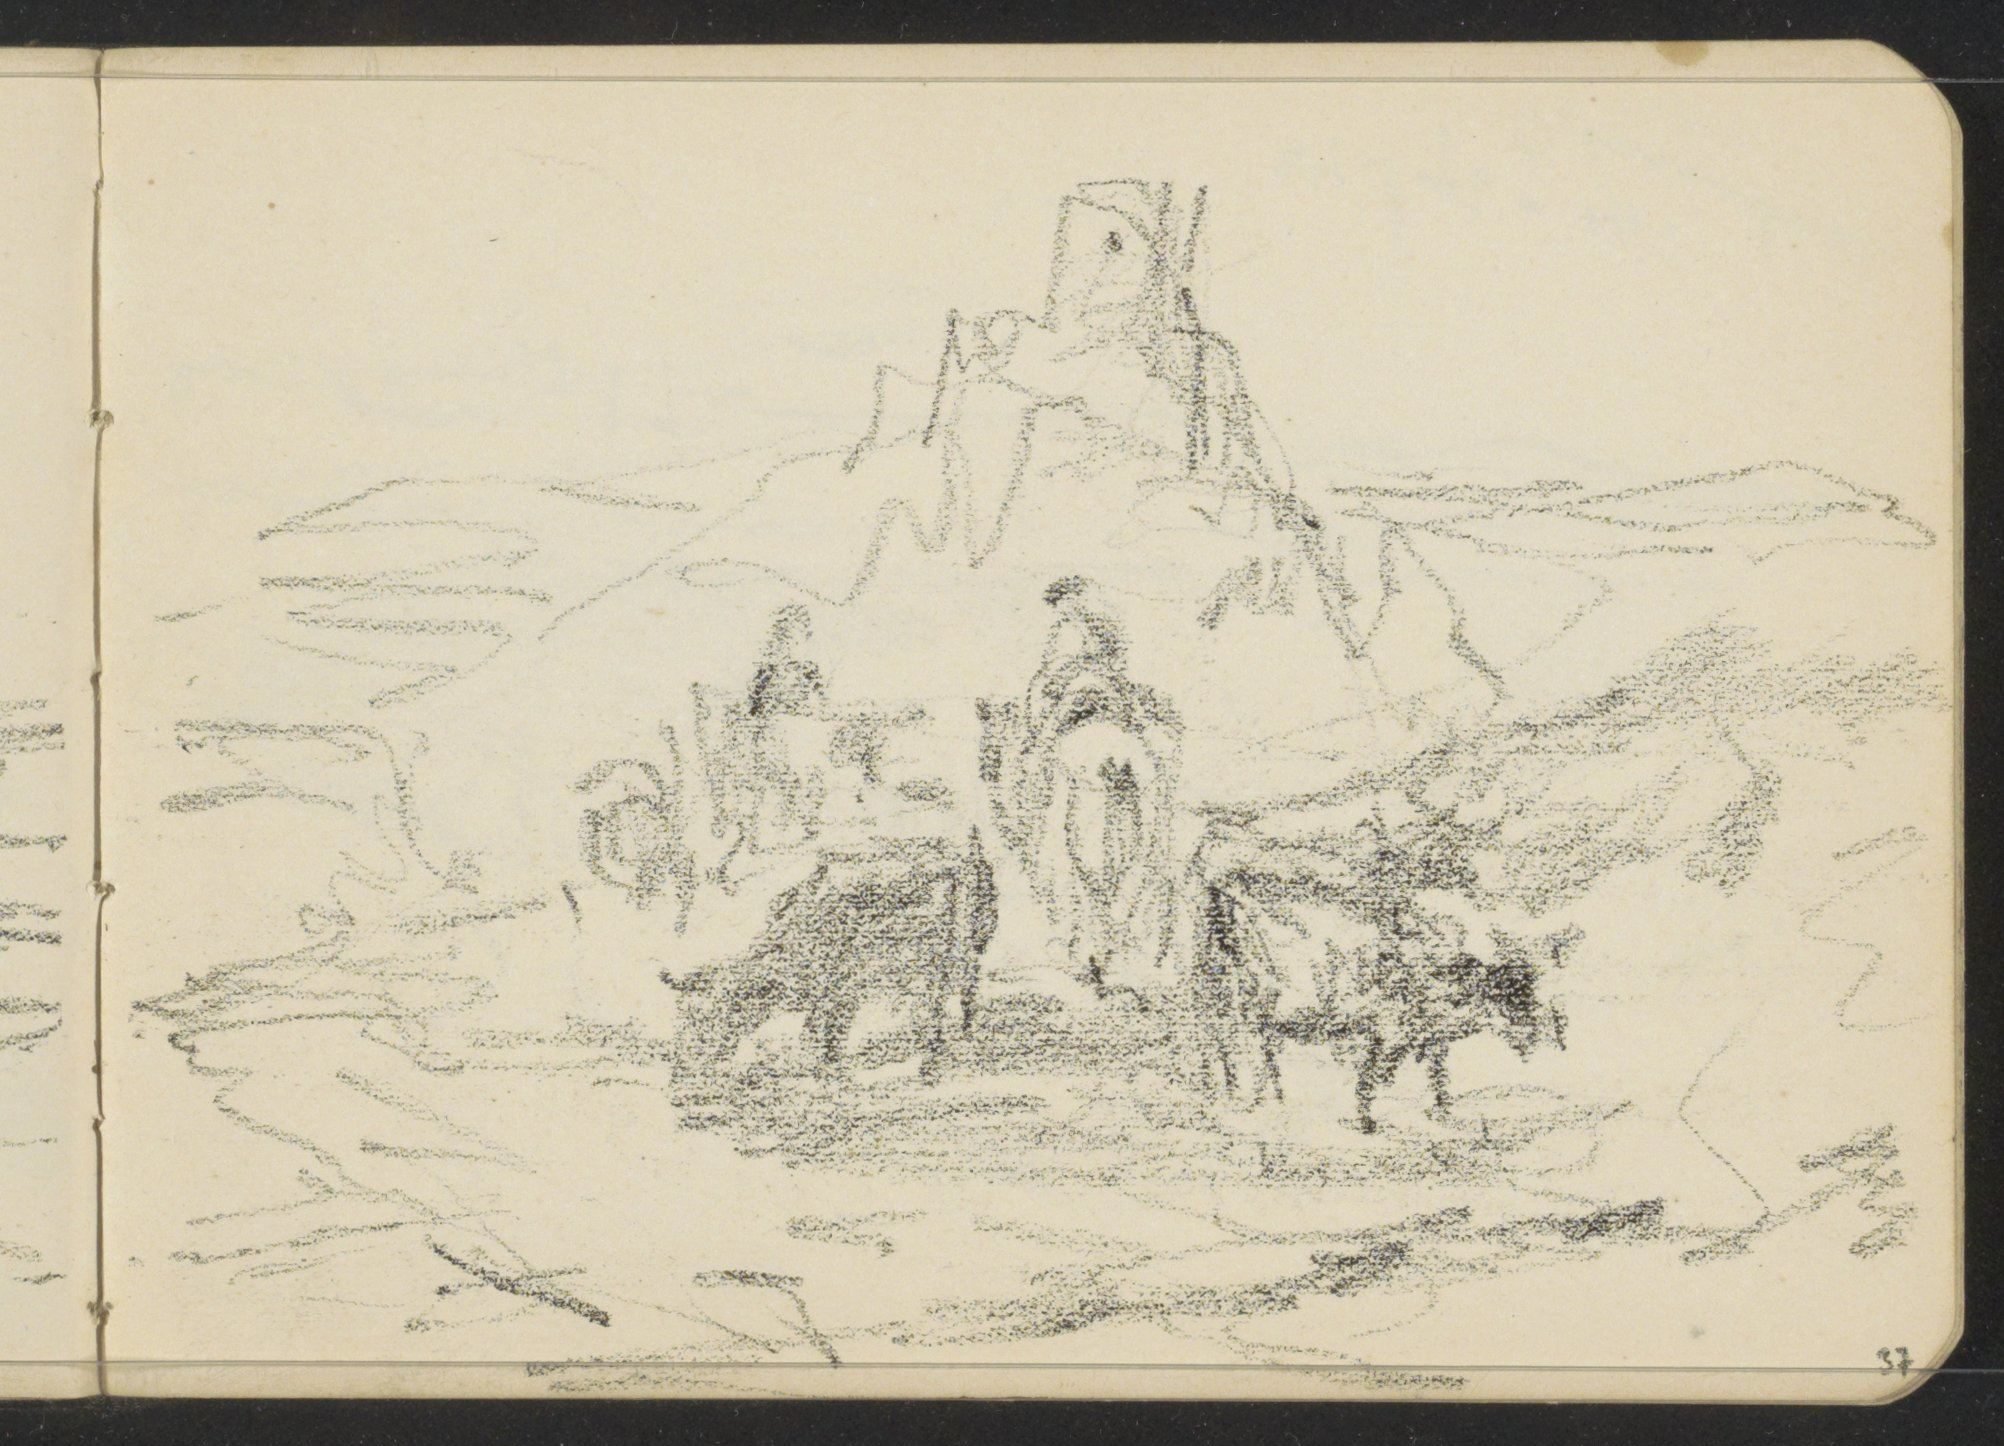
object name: sketchbook leaf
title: Ruiter en vee voor een heuvel met een toren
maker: willem cornelis rip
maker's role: draughtsman, painter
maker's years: 1856-1922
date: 1914-1916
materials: chalk, paper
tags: riding a horse, ass, or mule; rider, horseman, cattle, (high) hill, city-view, and landscape with man-made constructions (+ city(-scape) with figures, staffage)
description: Blad 37 recto uit een schetsboek met 41 bladen.